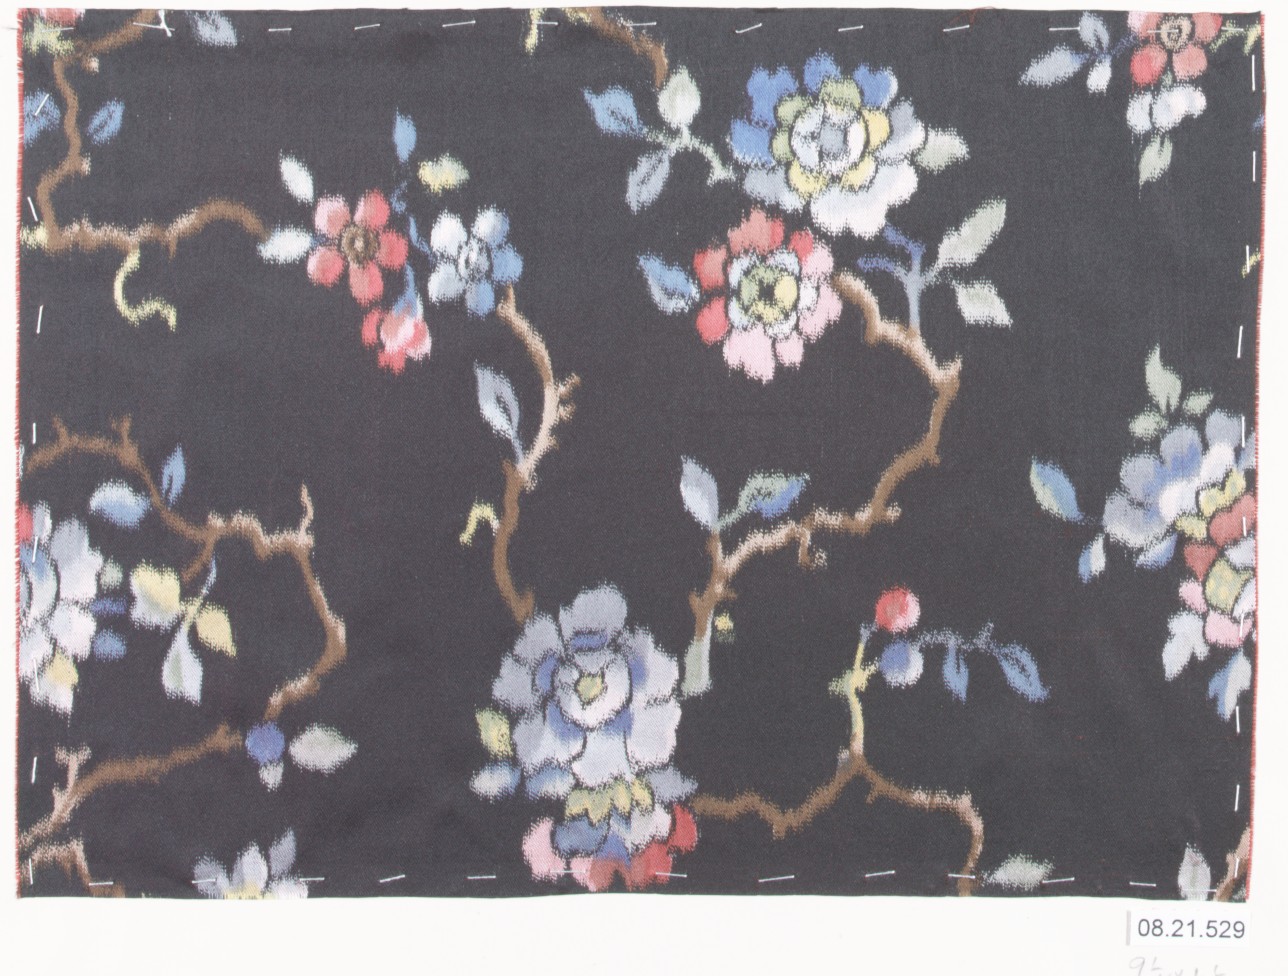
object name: textile sample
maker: Anonymous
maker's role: designer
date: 1900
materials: silk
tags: flowers